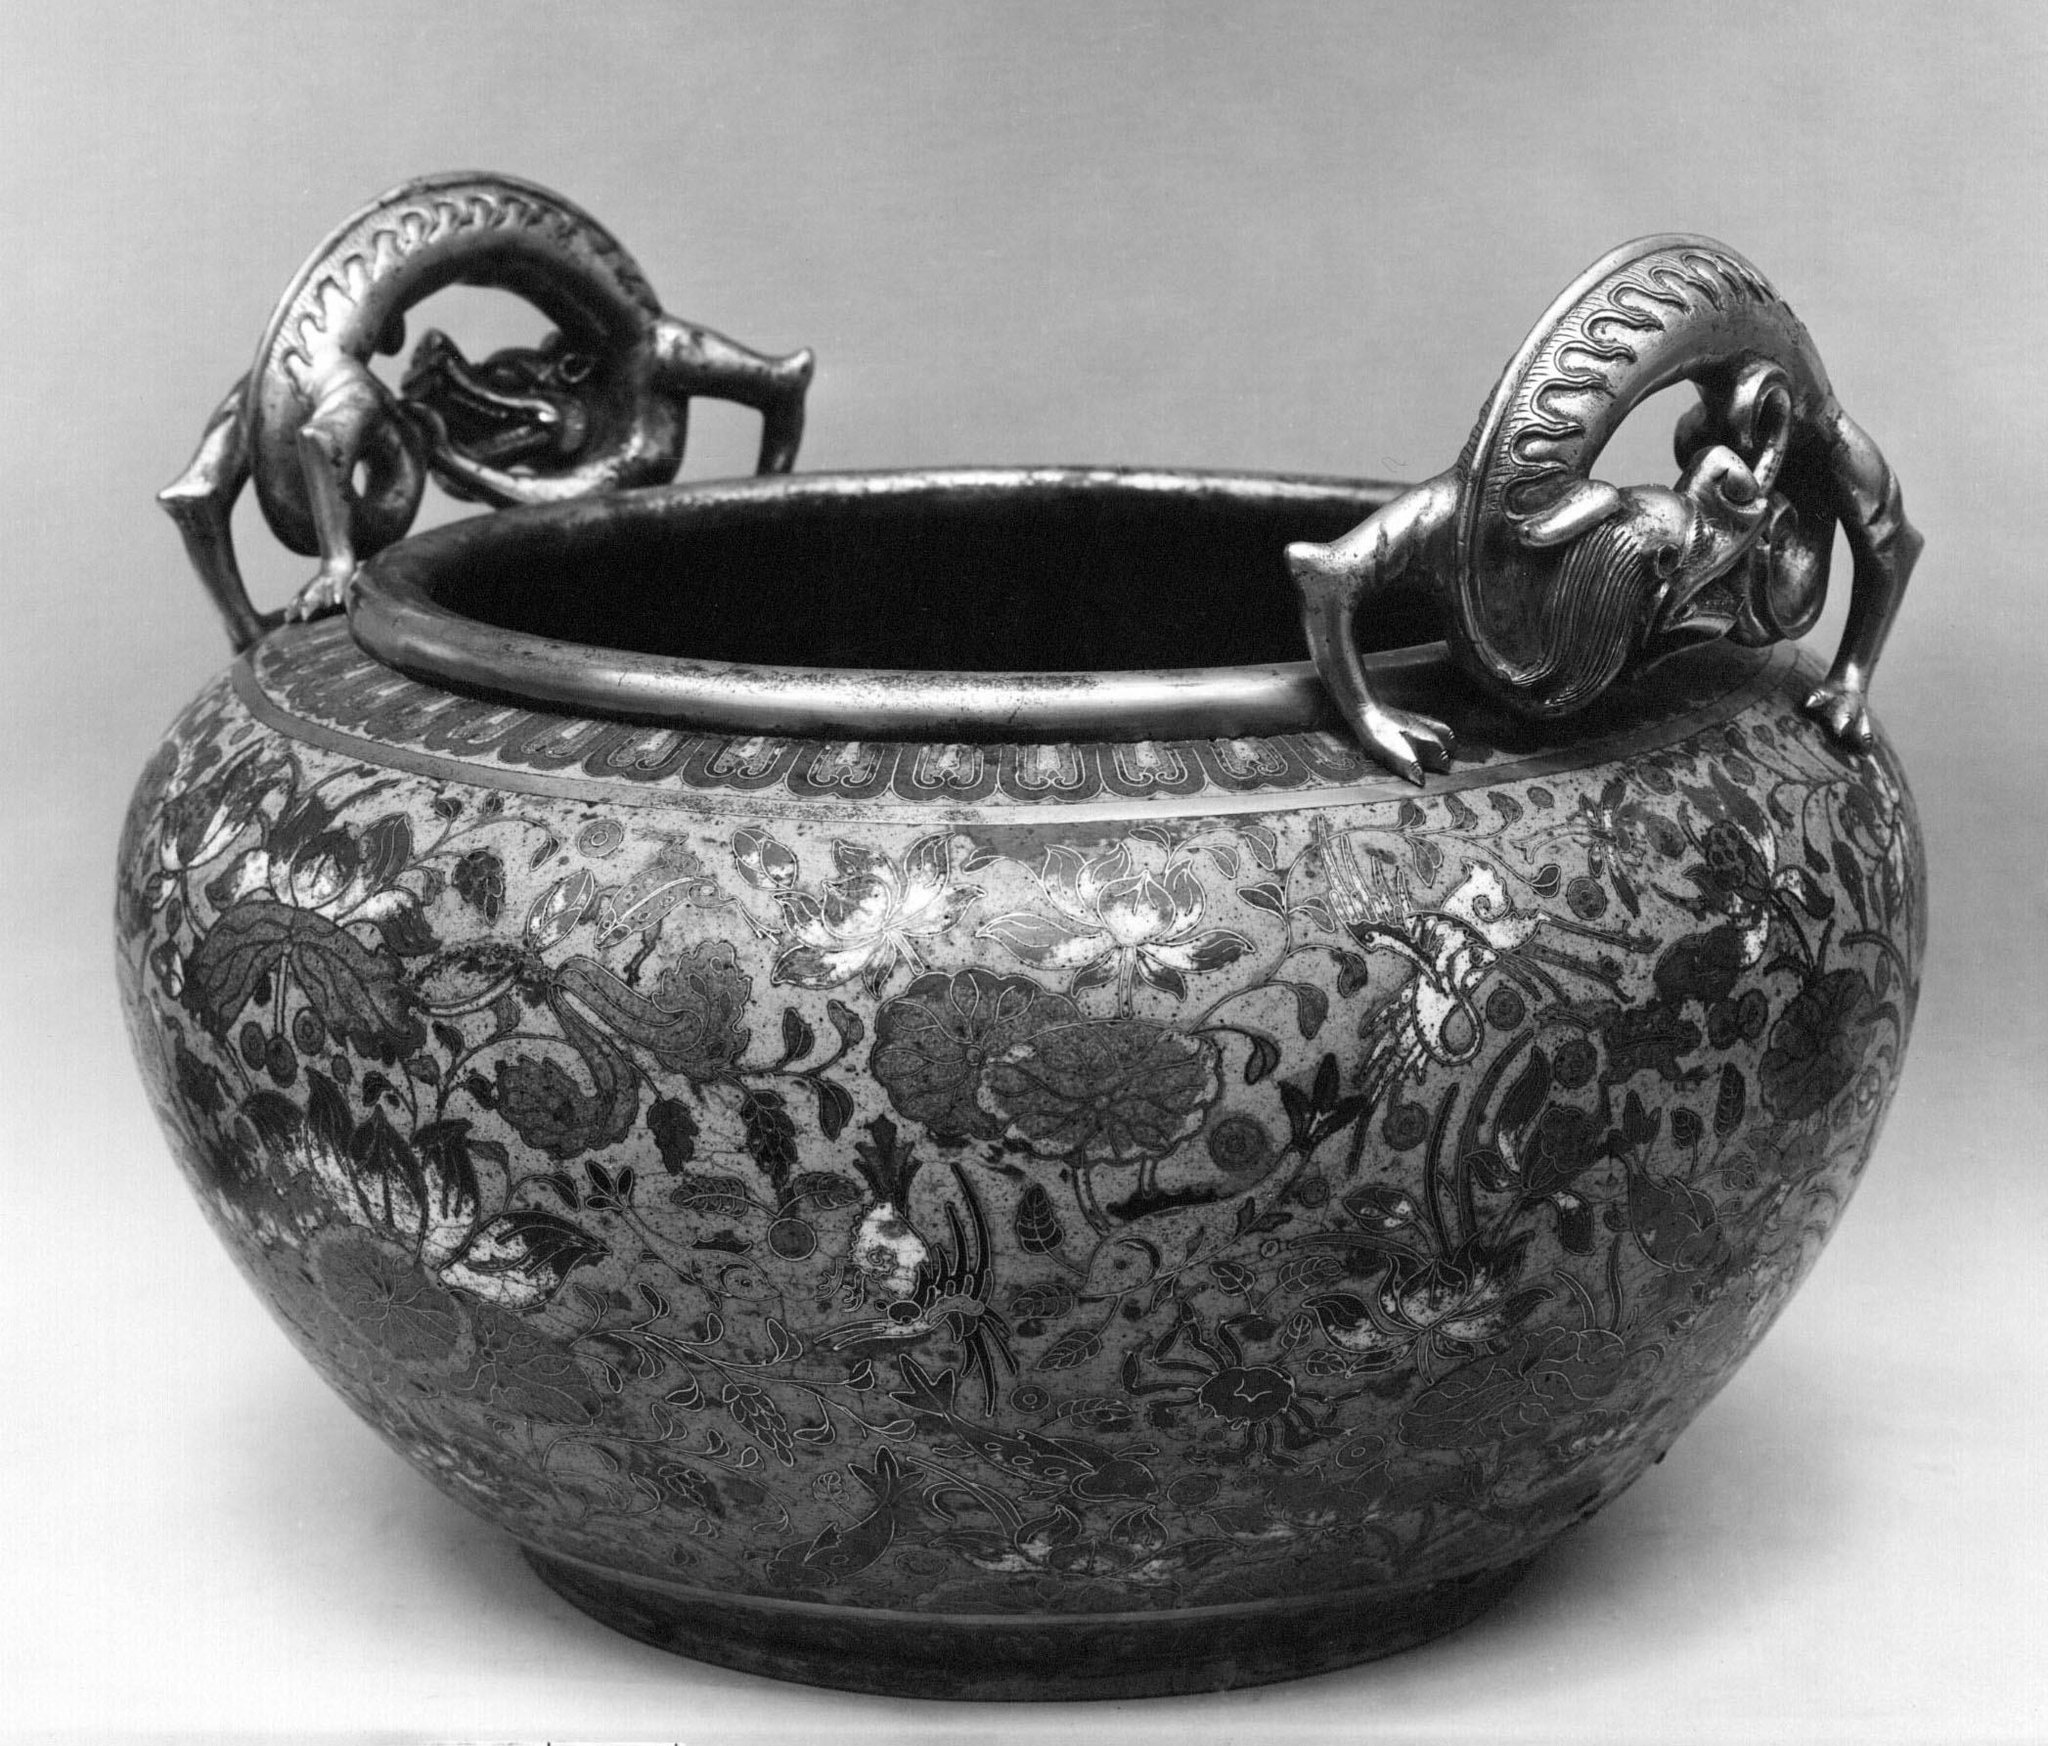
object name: bowl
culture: chinese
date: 1368-1644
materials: copper, enamel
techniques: enamel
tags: flowers